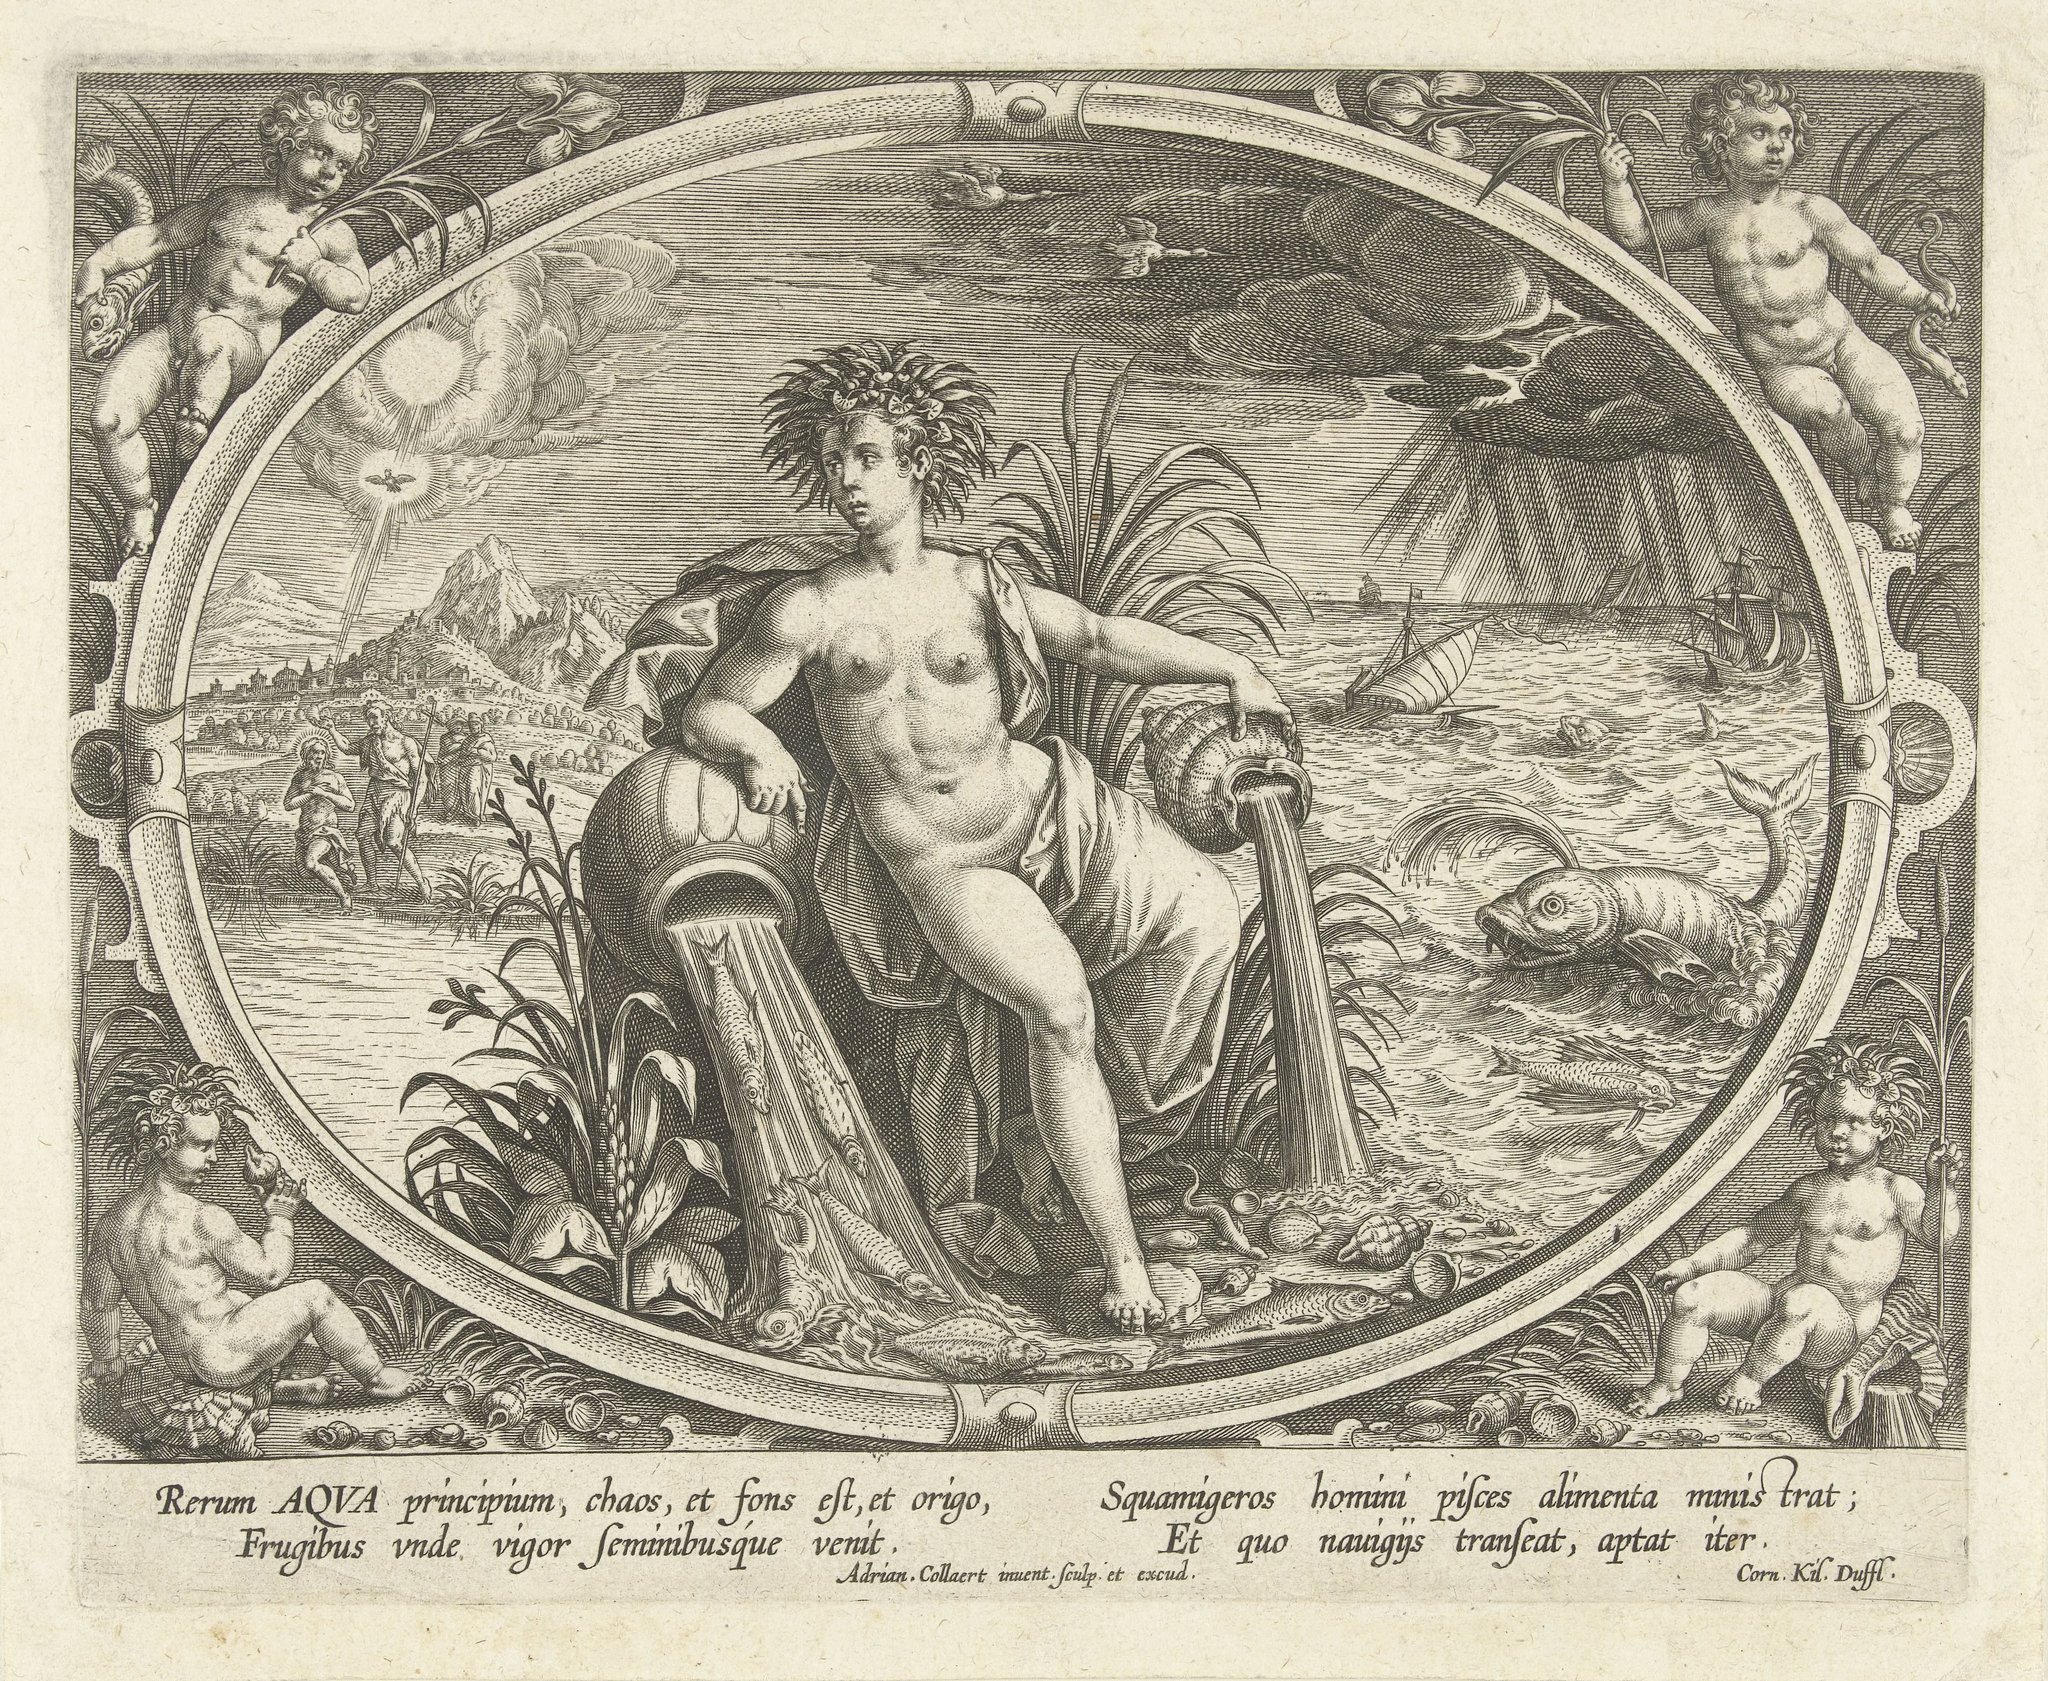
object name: print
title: De vier elementen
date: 1570-1618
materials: paper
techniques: engraving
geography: antwerp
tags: baptism of christ in the river jordan: john the baptist pouring out water on christ's head: the holy ghost descends, water (one of the four elements)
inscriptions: collector's mark: Lugt 2228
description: In een ovale lijst het element water, gepersonifieerd door een naakte riviergodin. Zij is omringd door water. Links een rivier, rechts een zee met zeemonsters en schepen. Uit een schelp en een urn naast haar stroomt water. Op de achtergrond de doop van Christus door Johannes de Doper. In de vier hoeken van de prent putti. De prent heeft een Latijns onderschrift en is deel van een vierdelige serie over de vier elementen.